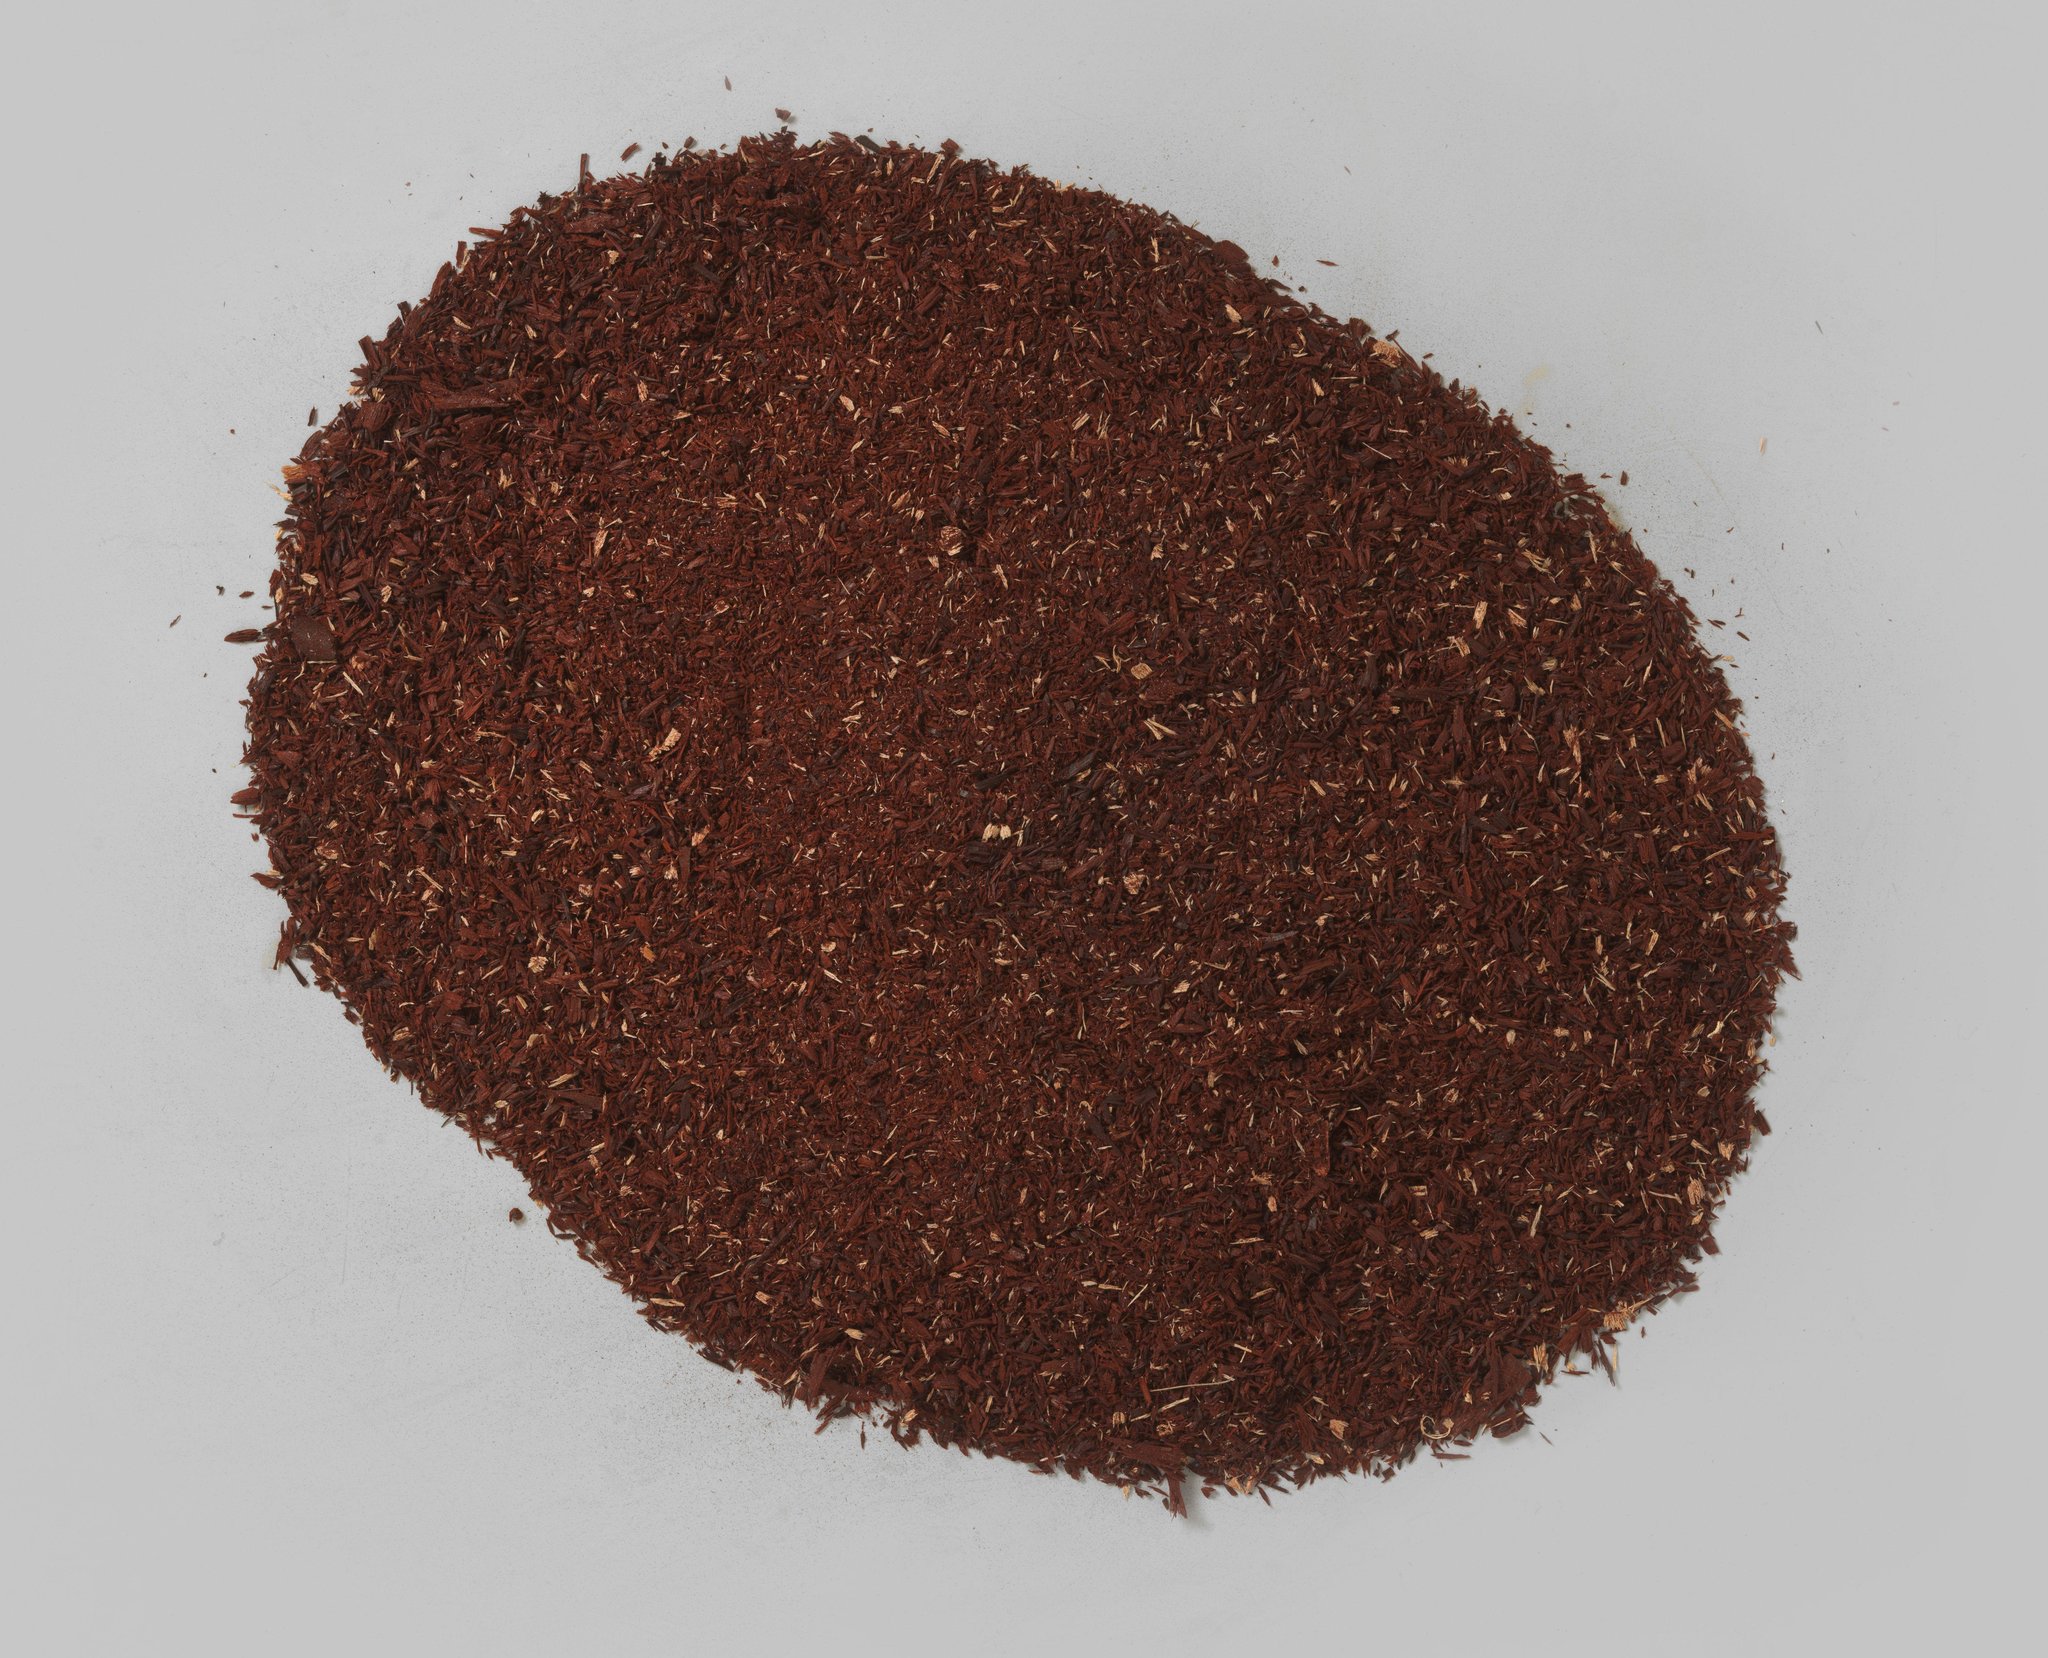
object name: sample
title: Bodemmonster uit het wrak van de Oostindiëvaarder Hollandia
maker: Anonymous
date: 1700-1743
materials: organic material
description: Bodemmonster(?), zak met plantaardig materiaal.